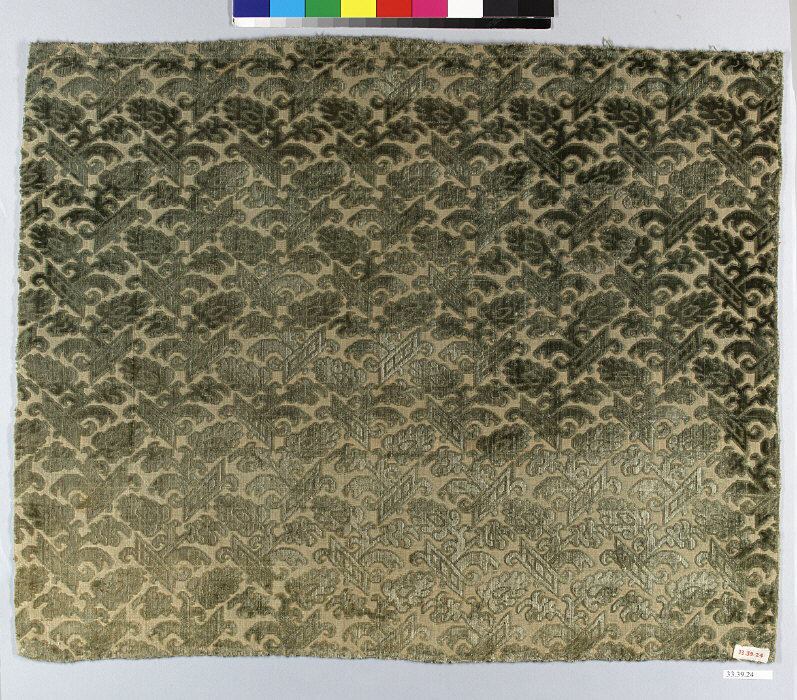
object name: piece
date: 1501-1700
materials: silk